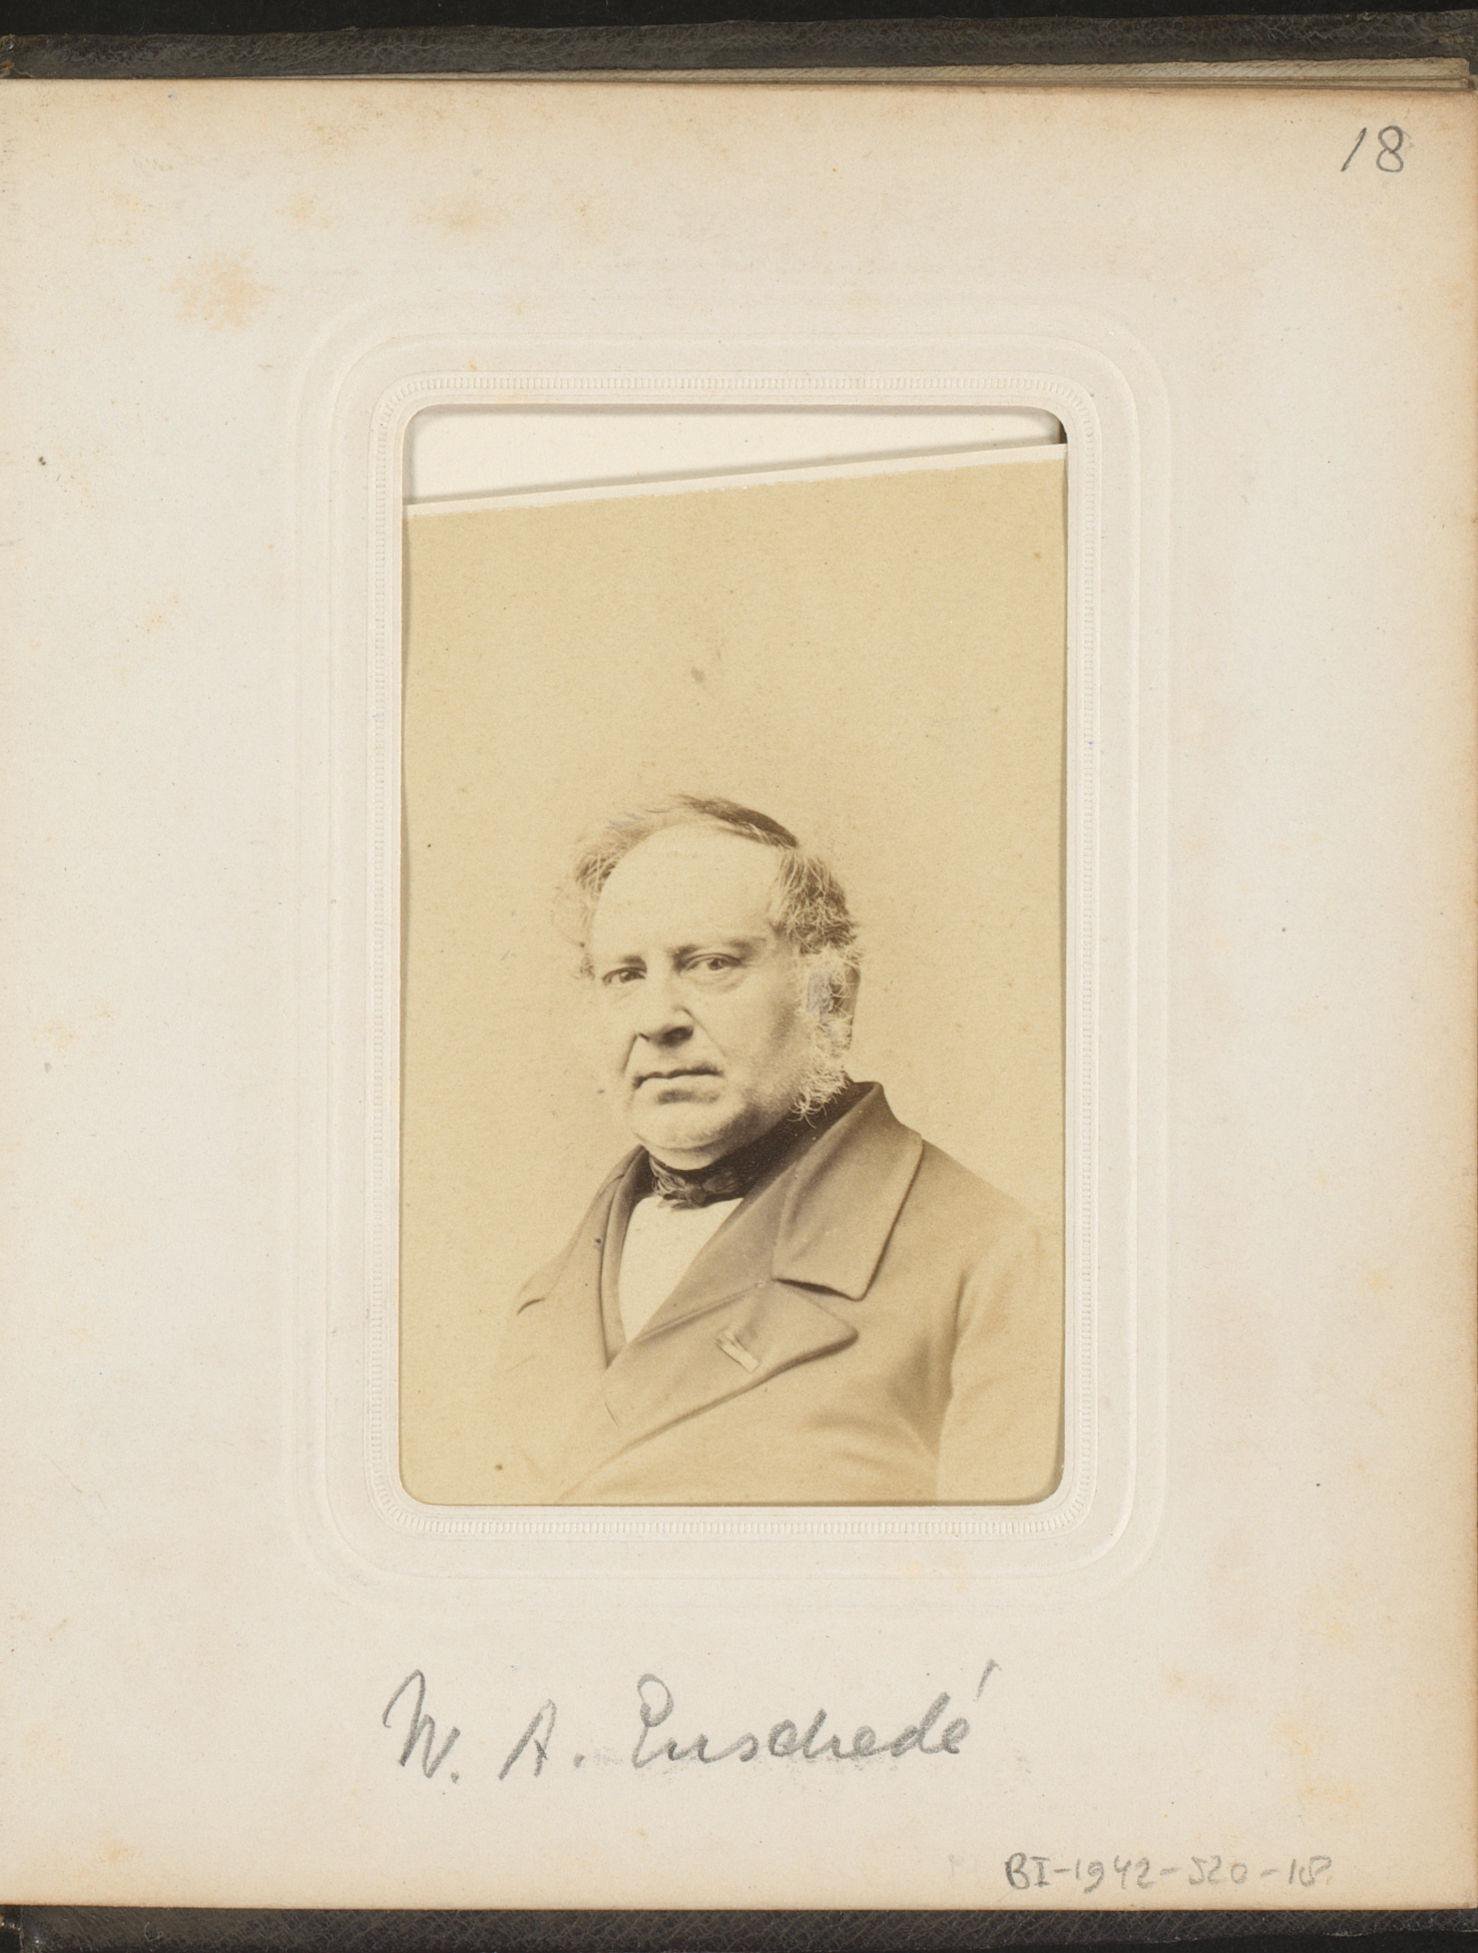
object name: photograph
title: Portret van Willem Adriaan Enschedé, hoogleraar in de faculteit Wis- en Natuurkunde aan de universiteit van Groningen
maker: johannes hinderikus egenberger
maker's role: draughtsman, print maker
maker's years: 1822-1897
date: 1864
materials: cardboard, paper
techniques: albumen print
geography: groningen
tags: historical persons, professor, groningen (province)